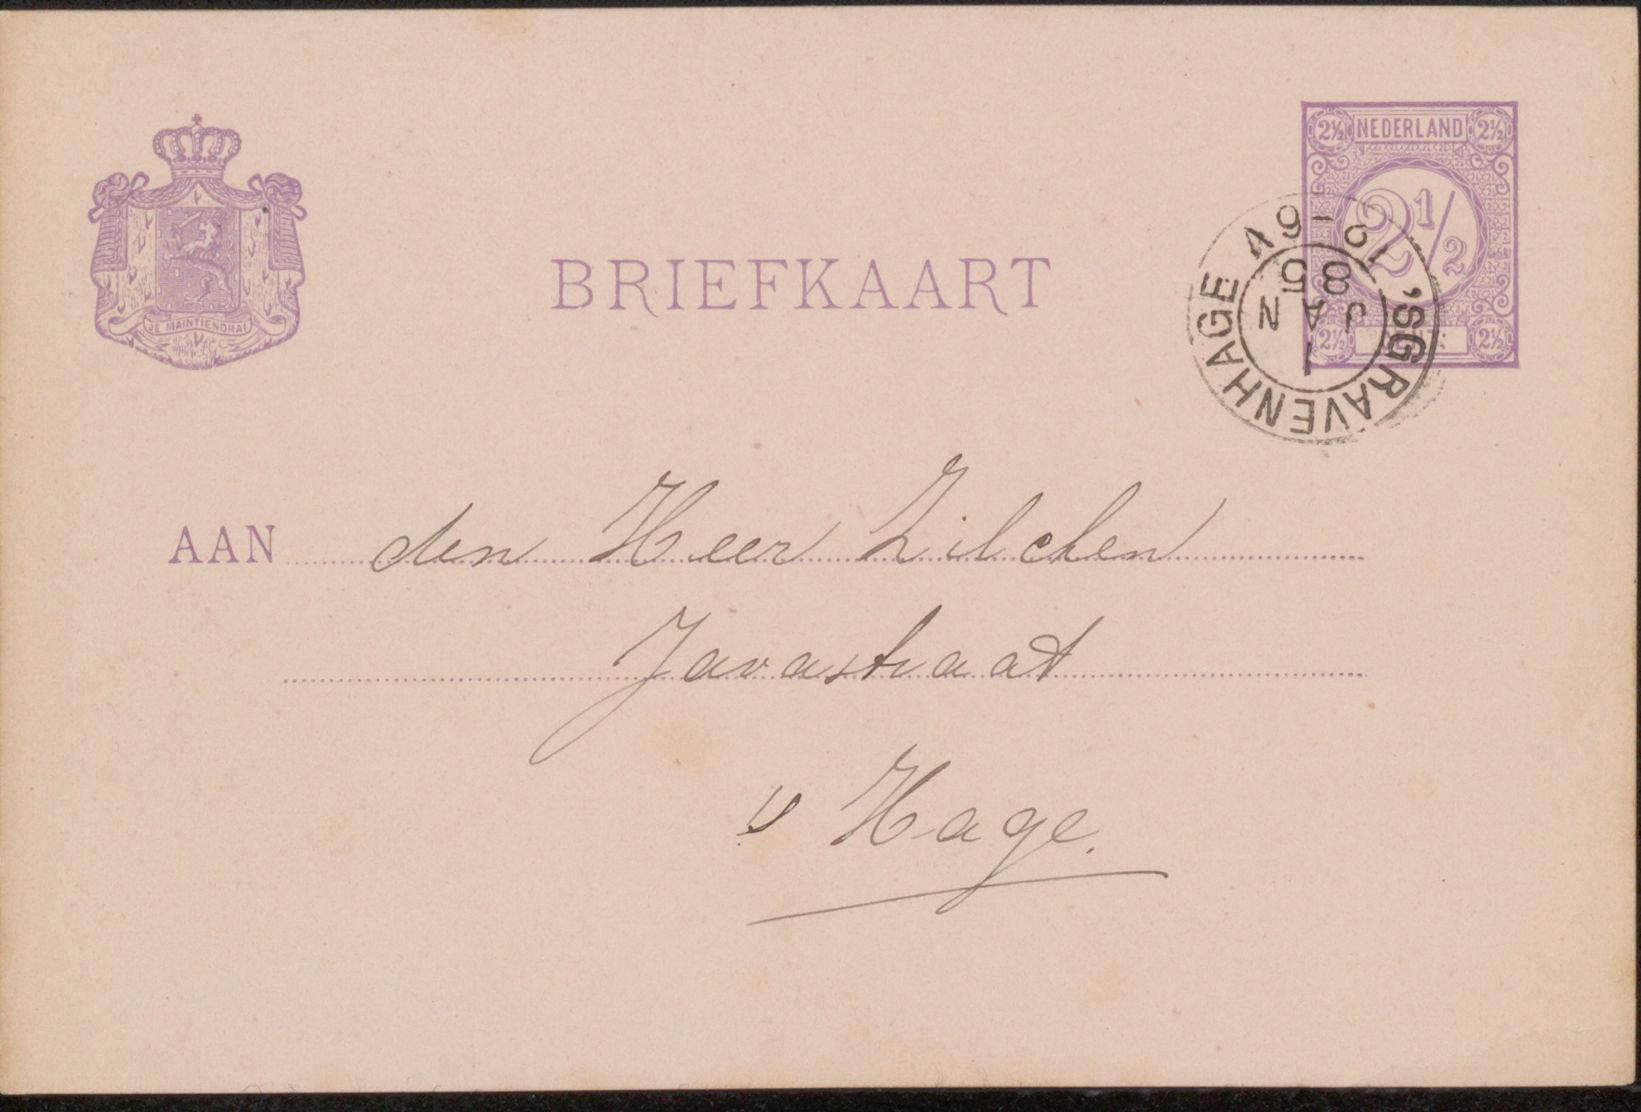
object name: postcard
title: Briefkaart aan Philip Zilcken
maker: barbara elisabeth van houten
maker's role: draughtsman, print maker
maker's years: 1862-1950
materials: cardboard, ink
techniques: pen, writing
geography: the hague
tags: painter, philip zilcken, brussels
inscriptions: collector's mark: ‘RPK’